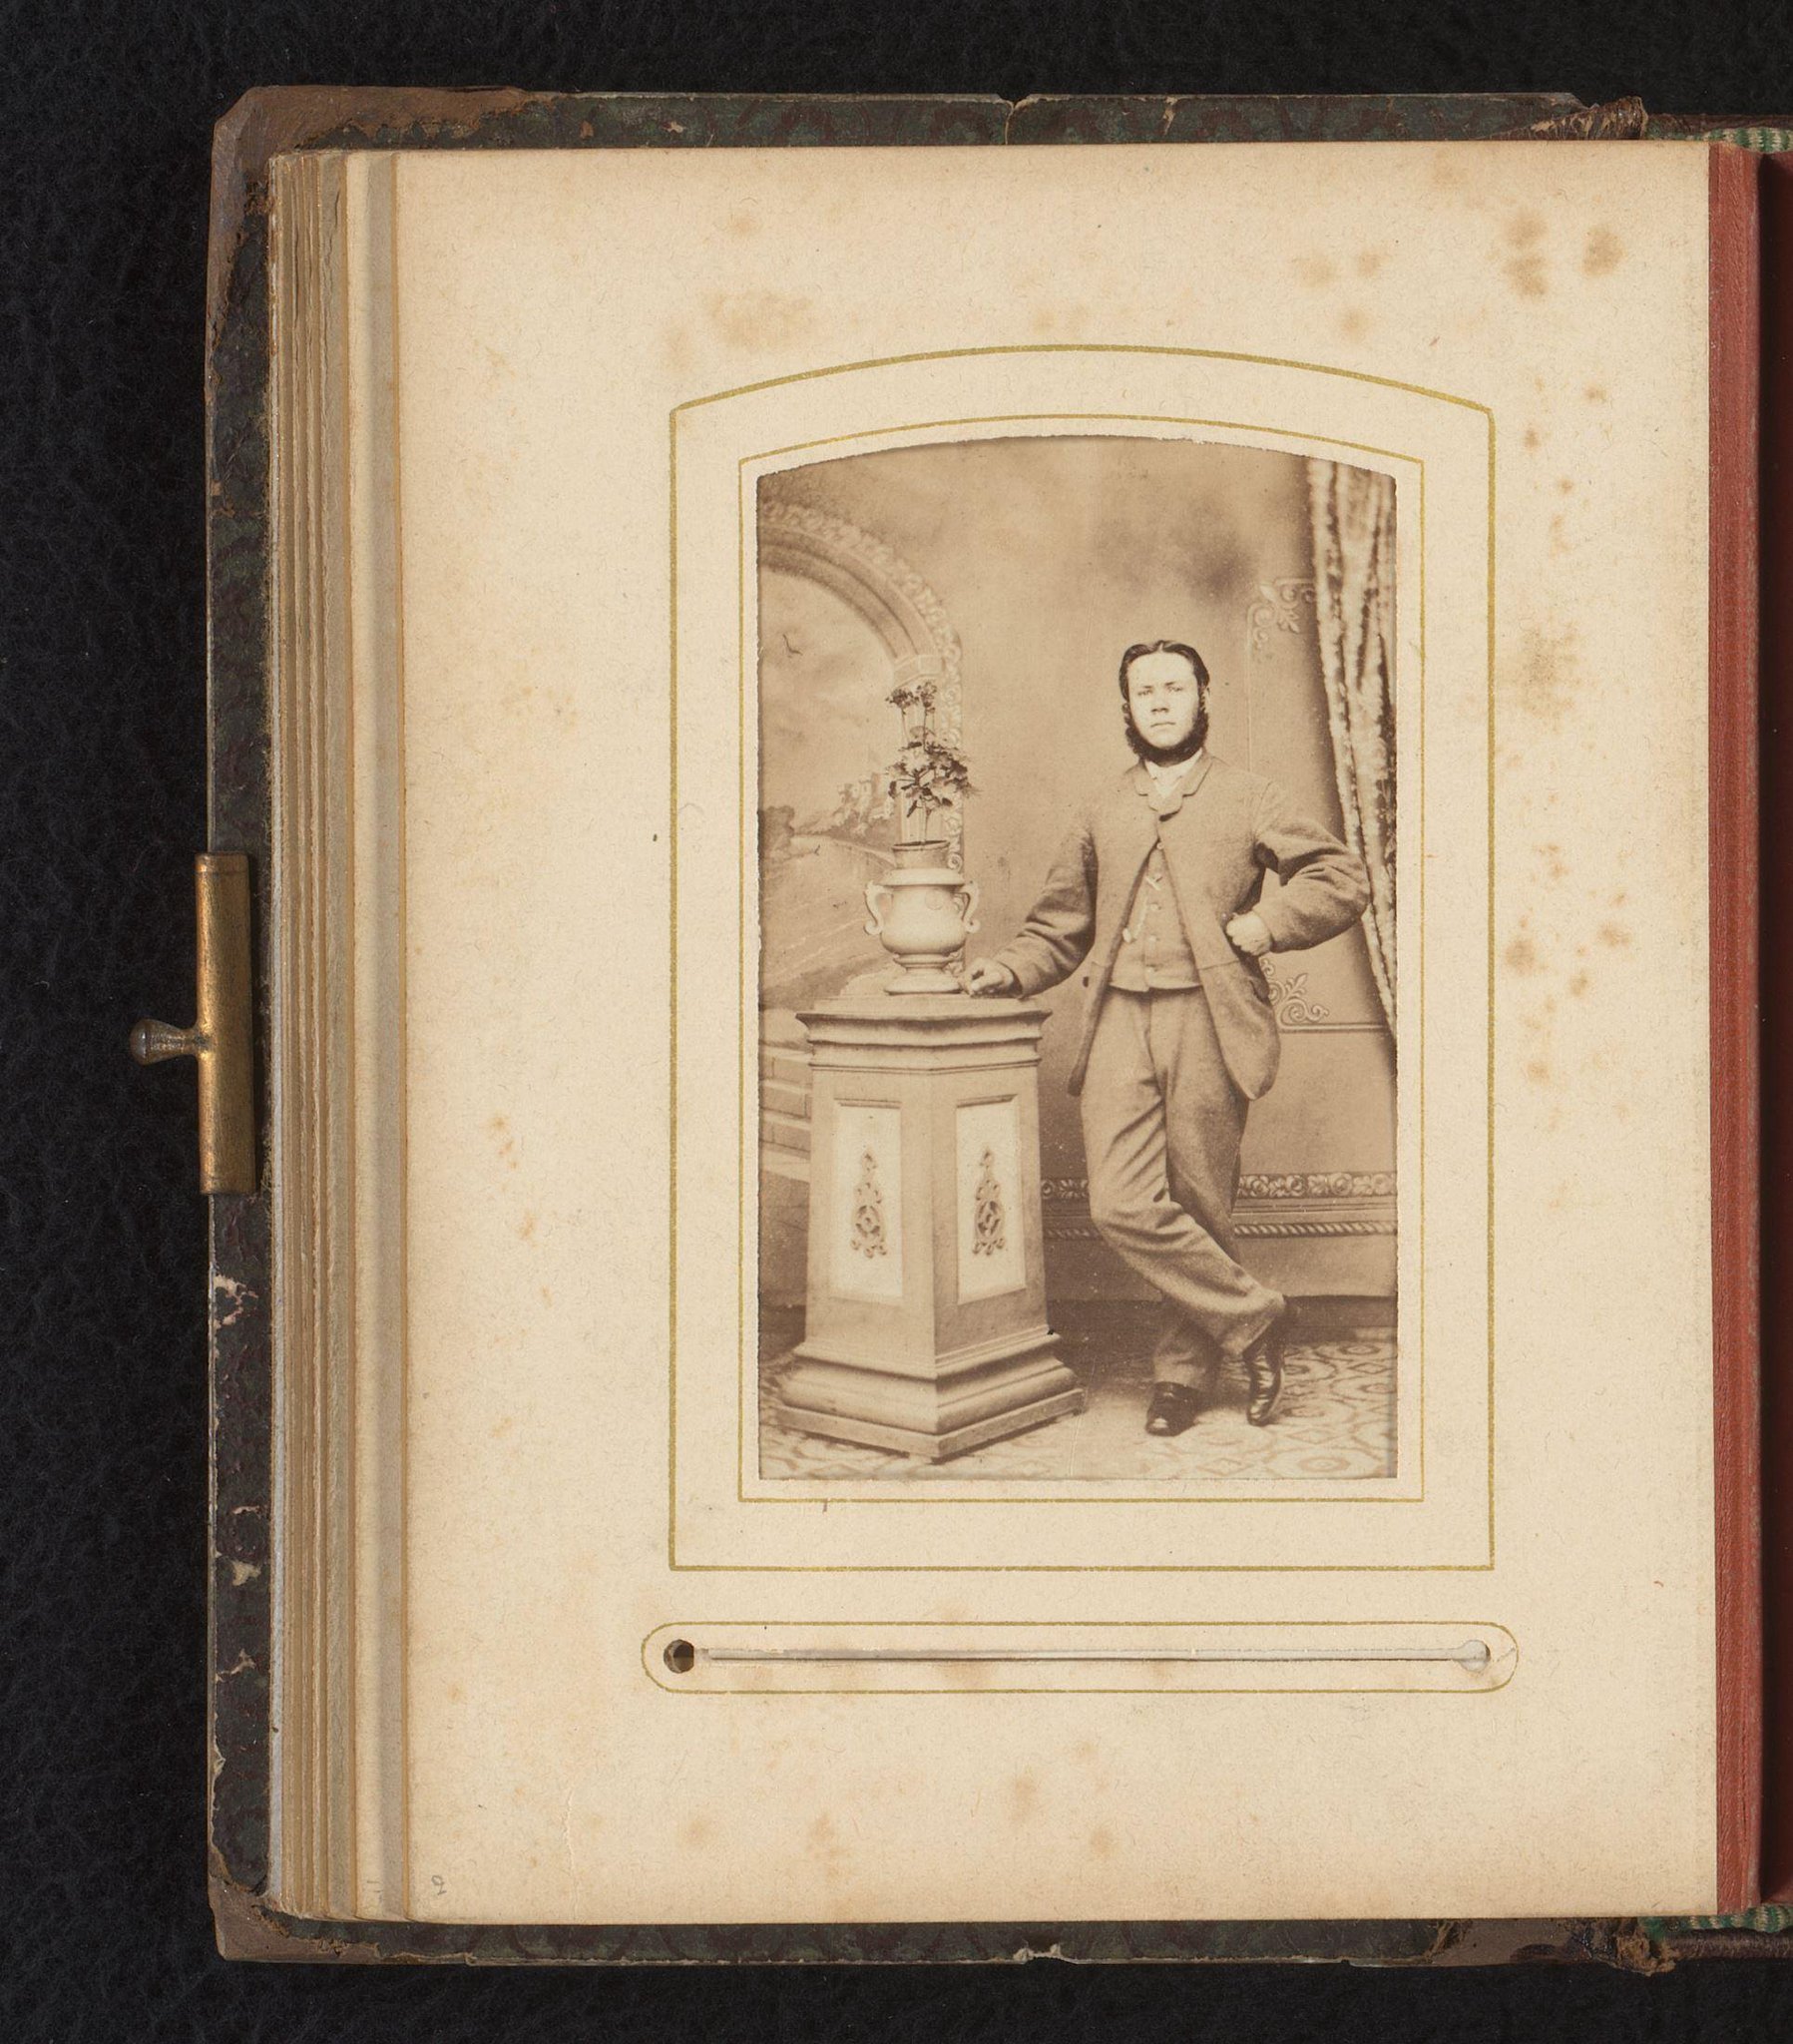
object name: album leaf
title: Portret van een man met baard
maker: j.w.t. rodd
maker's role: fotograaf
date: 1860-1900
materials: cardboard, photographic support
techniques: albumen print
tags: adult man, historical persons, beard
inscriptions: inscription: ‘Photographed by/ J.W.T. Rodd/3 Broad Street/ Kingsland Place/ Southampton (...)’